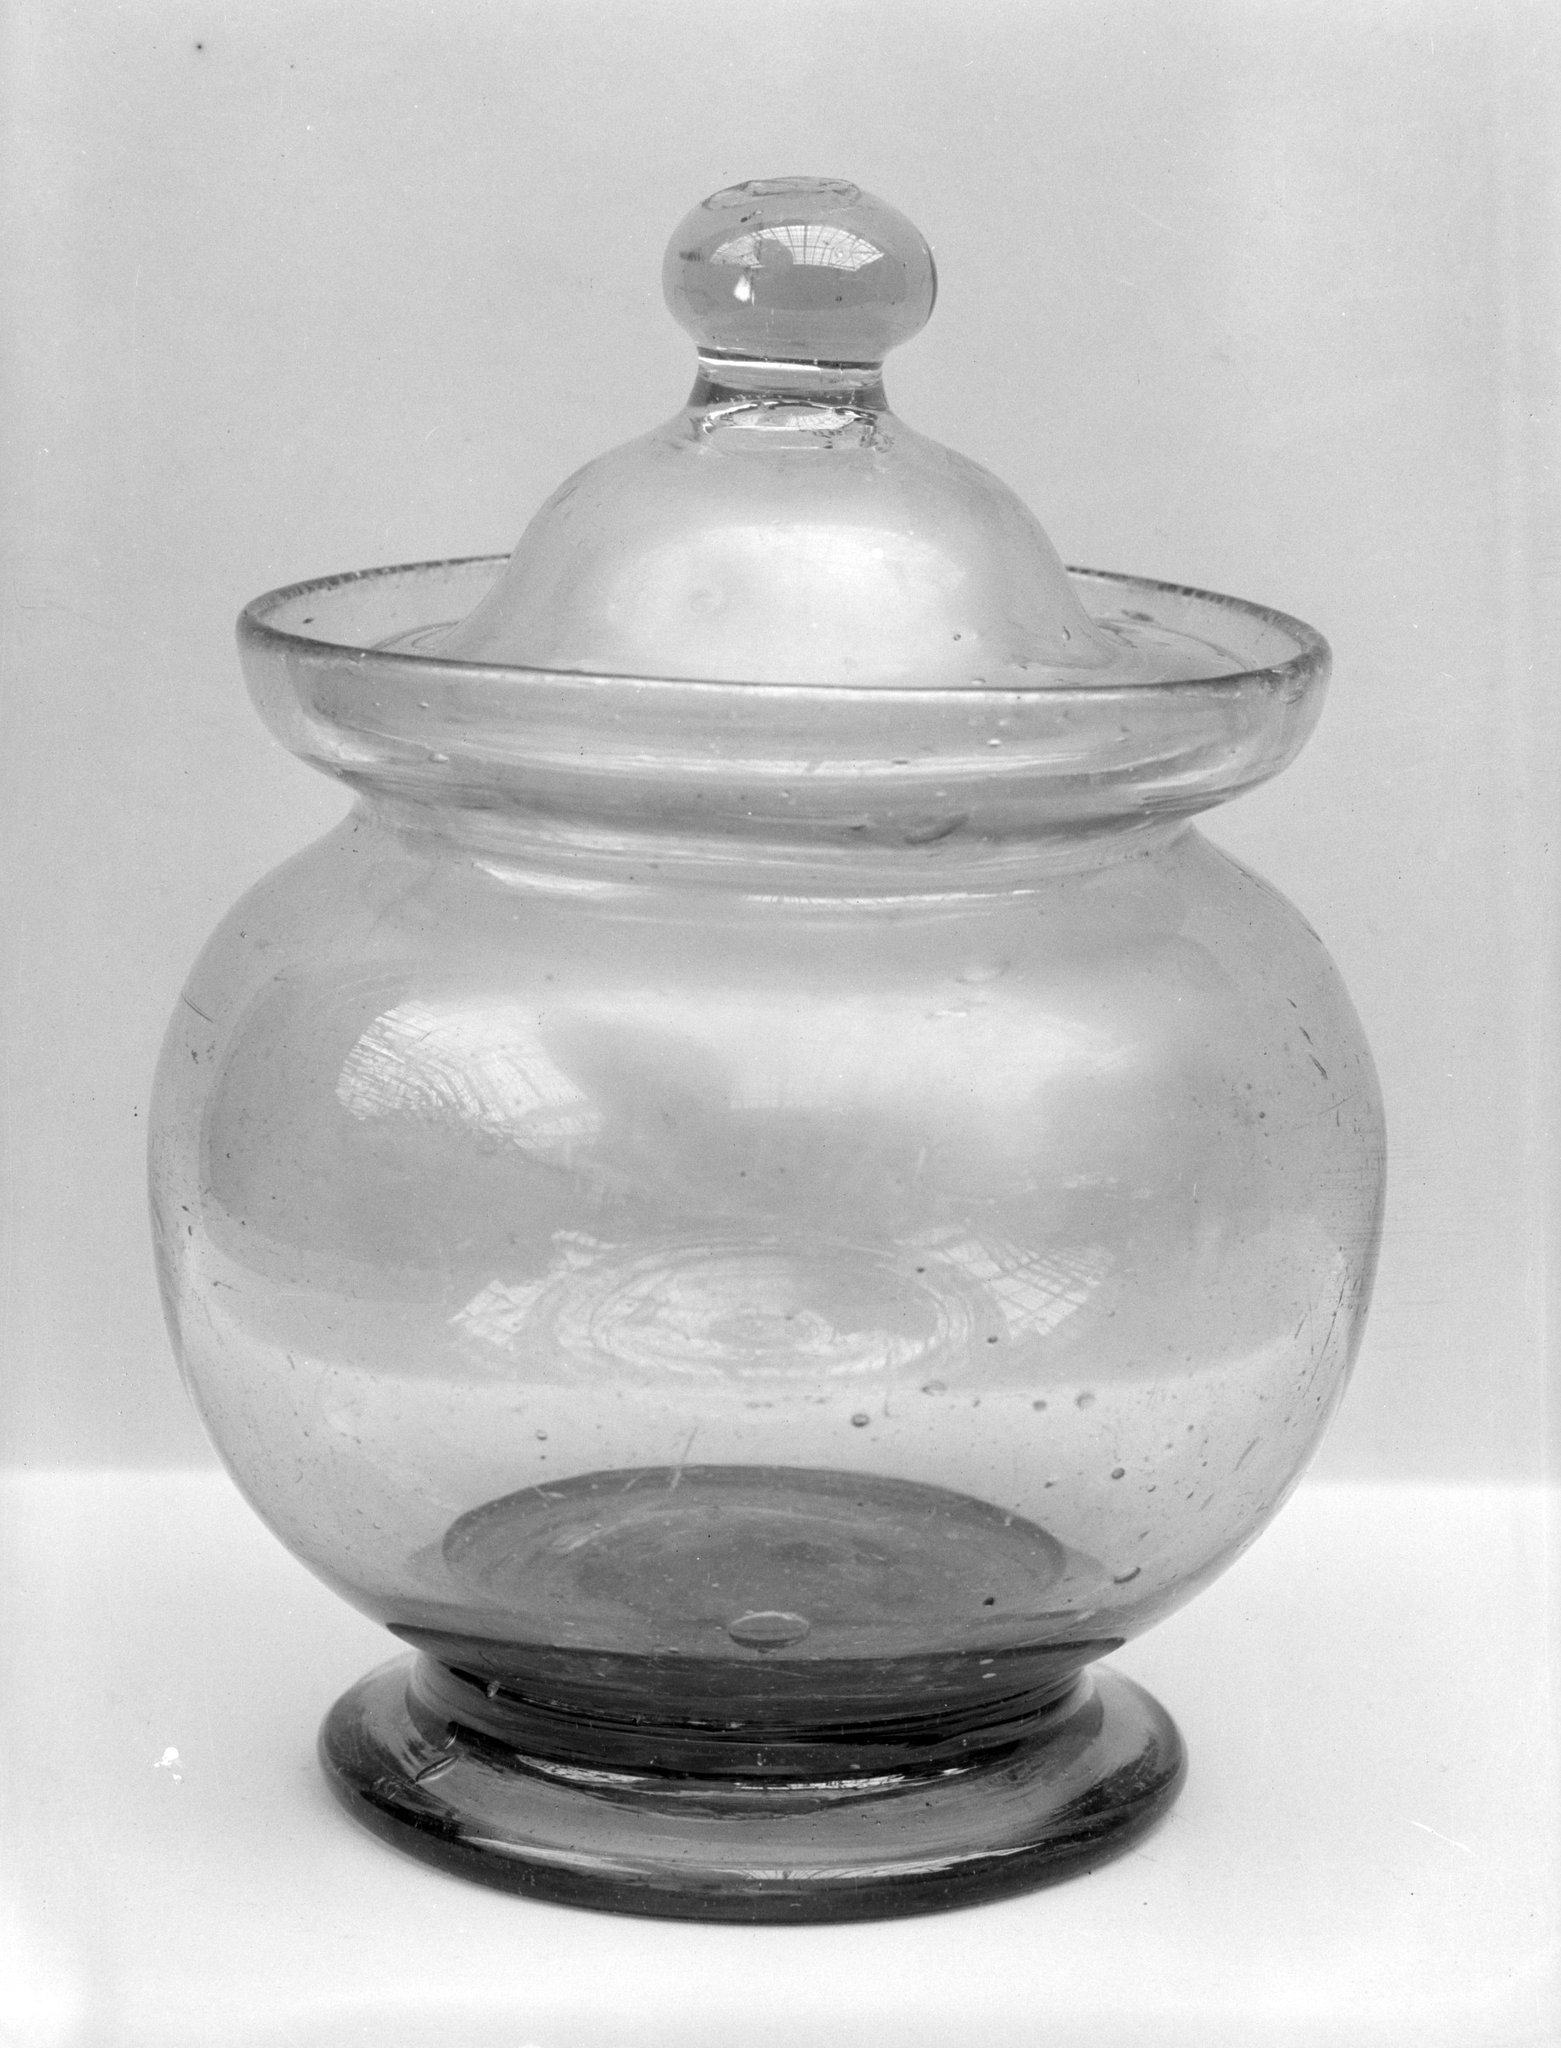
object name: bowl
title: Covered Bowl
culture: american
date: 1800-1850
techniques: glassblowing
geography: united states